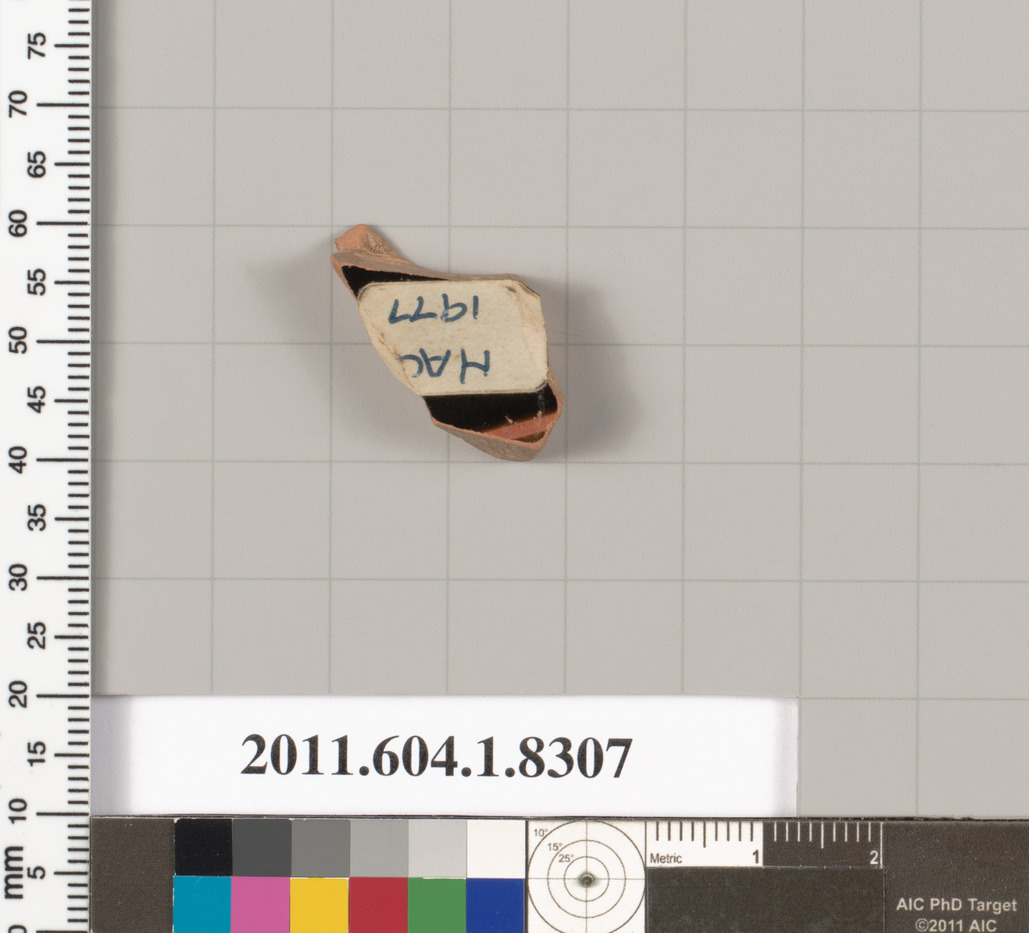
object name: kylix fragment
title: Terracotta fragment of a kylix (drinking cup)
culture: greek, attic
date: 400-376 BCE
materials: terracotta